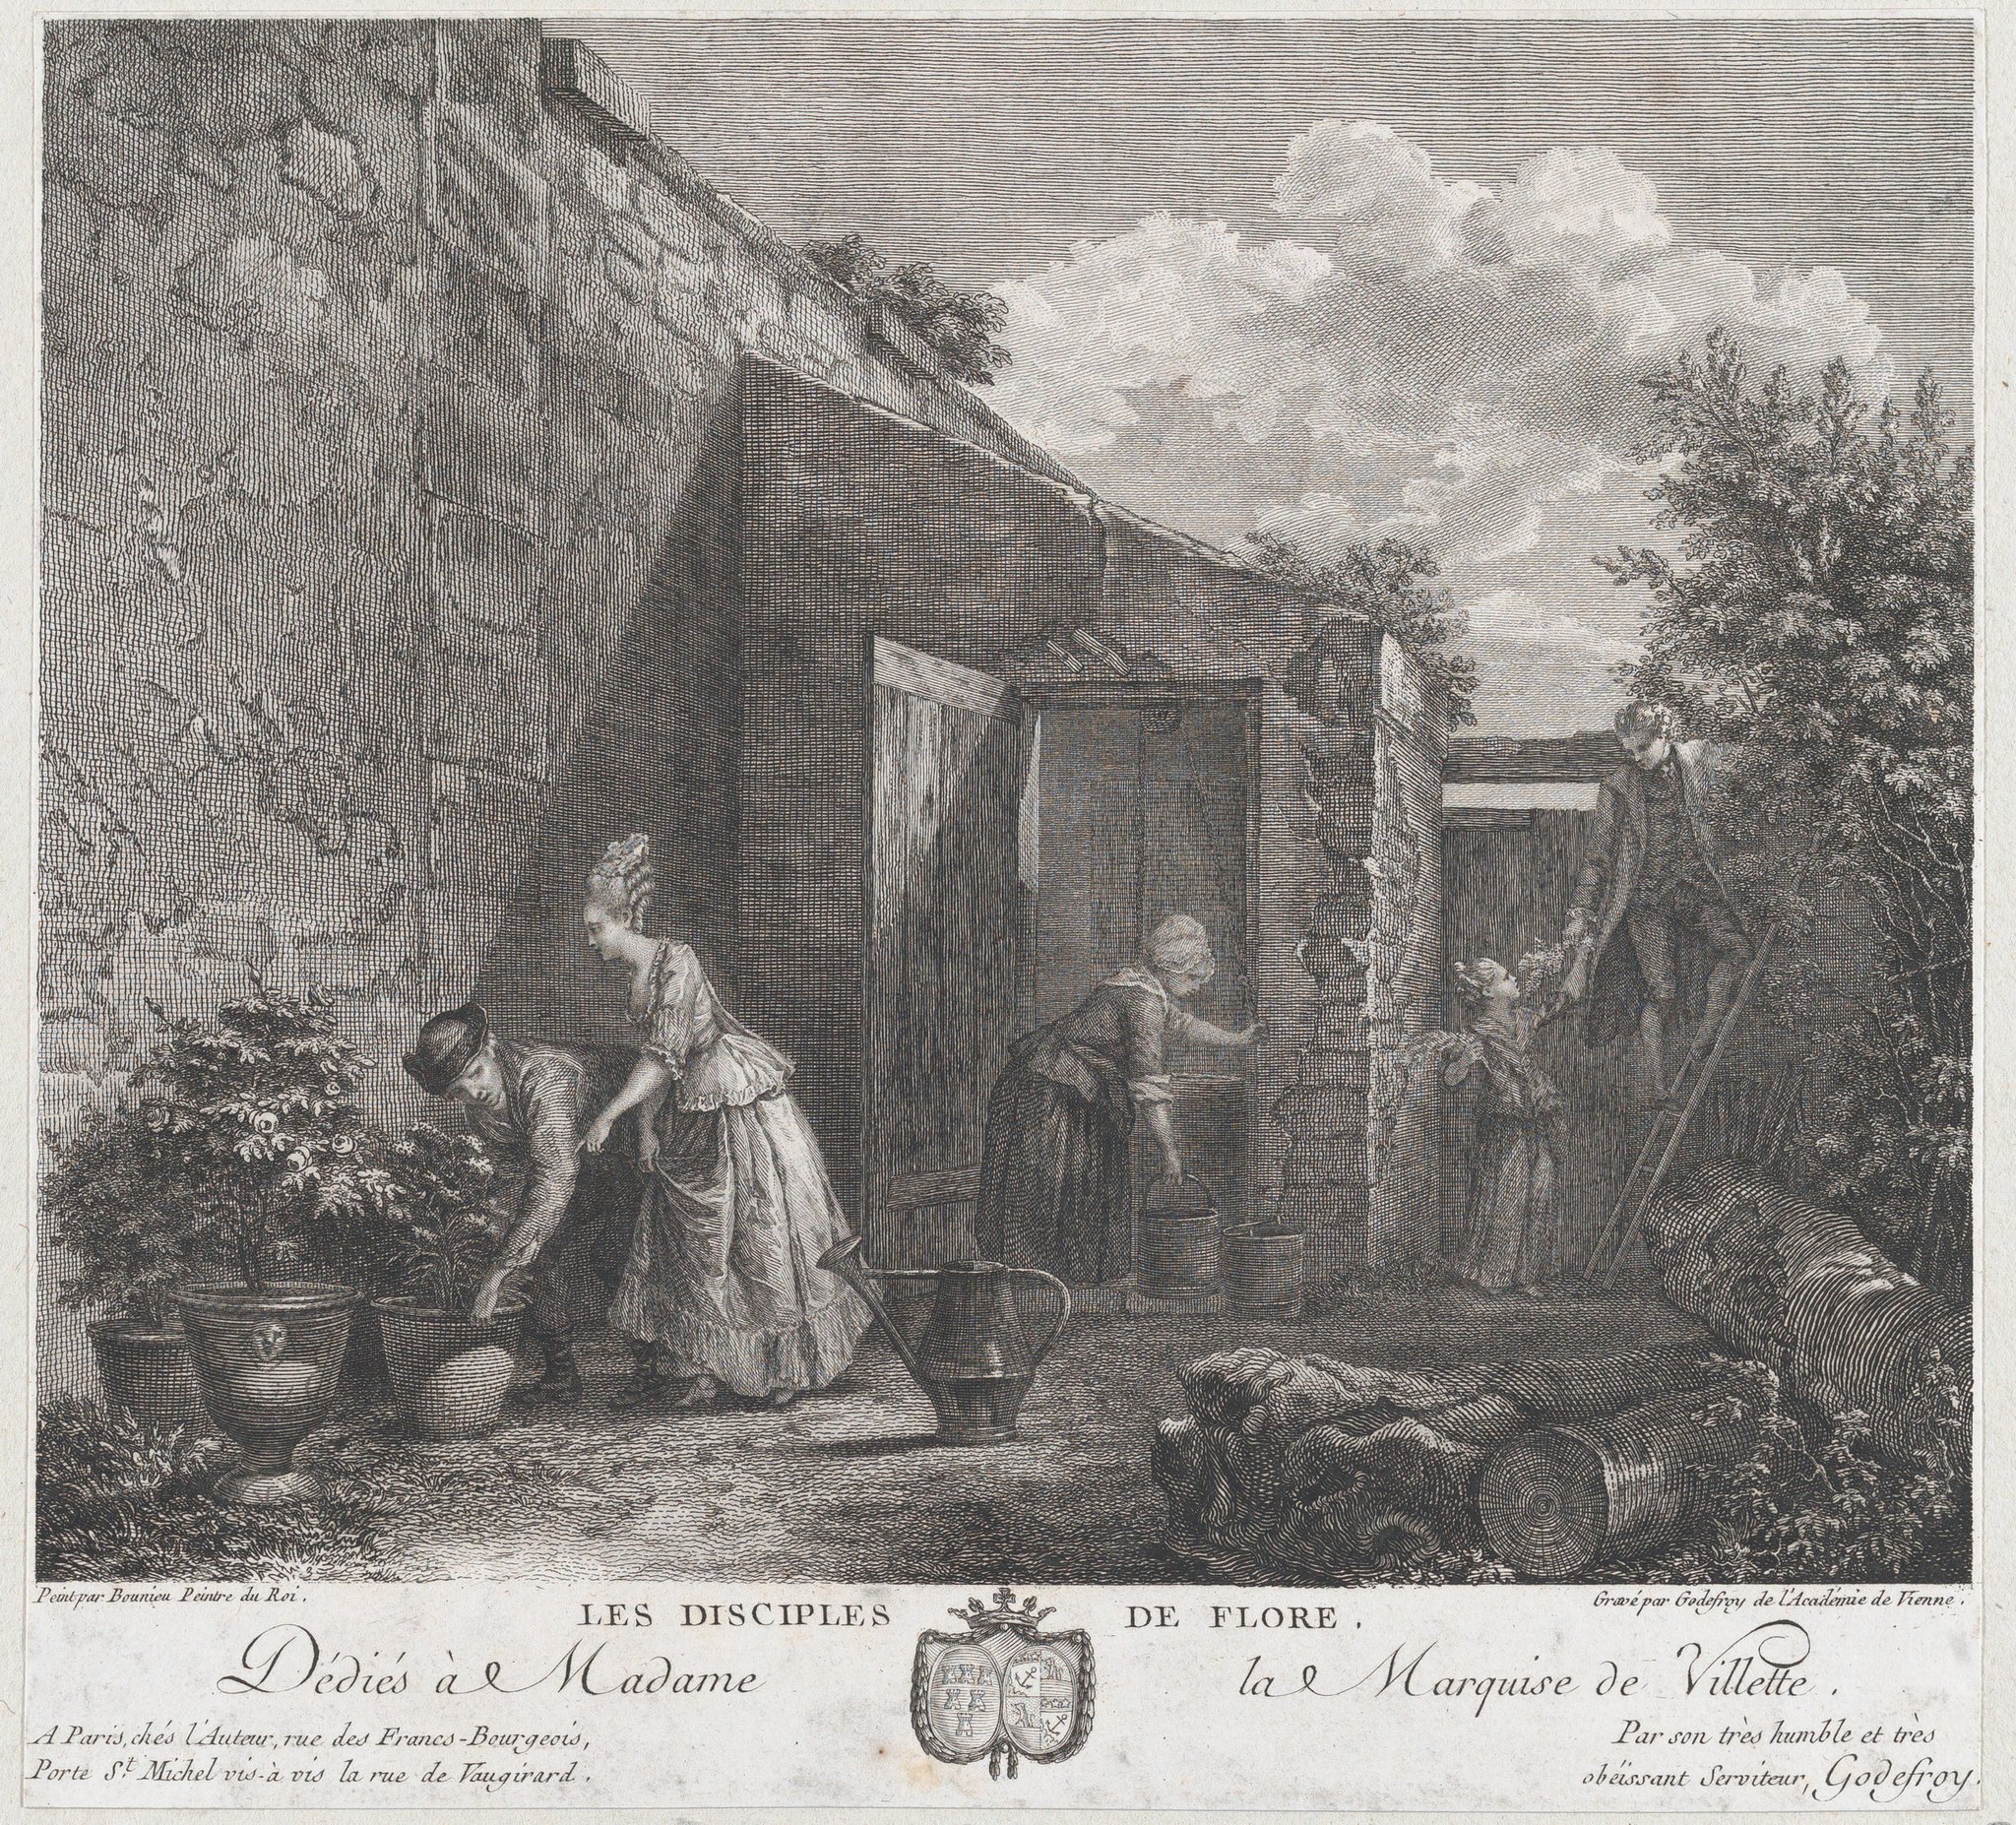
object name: print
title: The Disciples of Flora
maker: françois godefroy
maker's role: artist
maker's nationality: french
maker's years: 1743-1819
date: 1778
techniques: etching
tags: women,plants